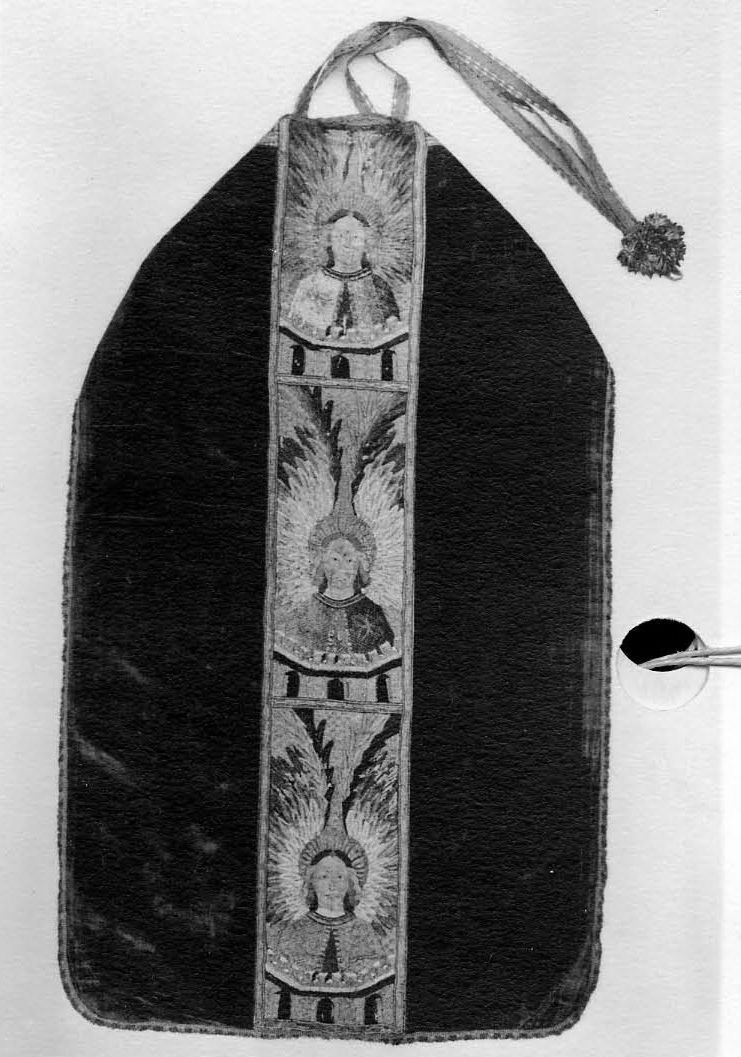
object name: chasuble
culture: rhenish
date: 1500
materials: silk